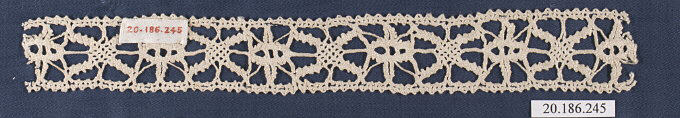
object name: insertion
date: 1501-1600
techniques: lace